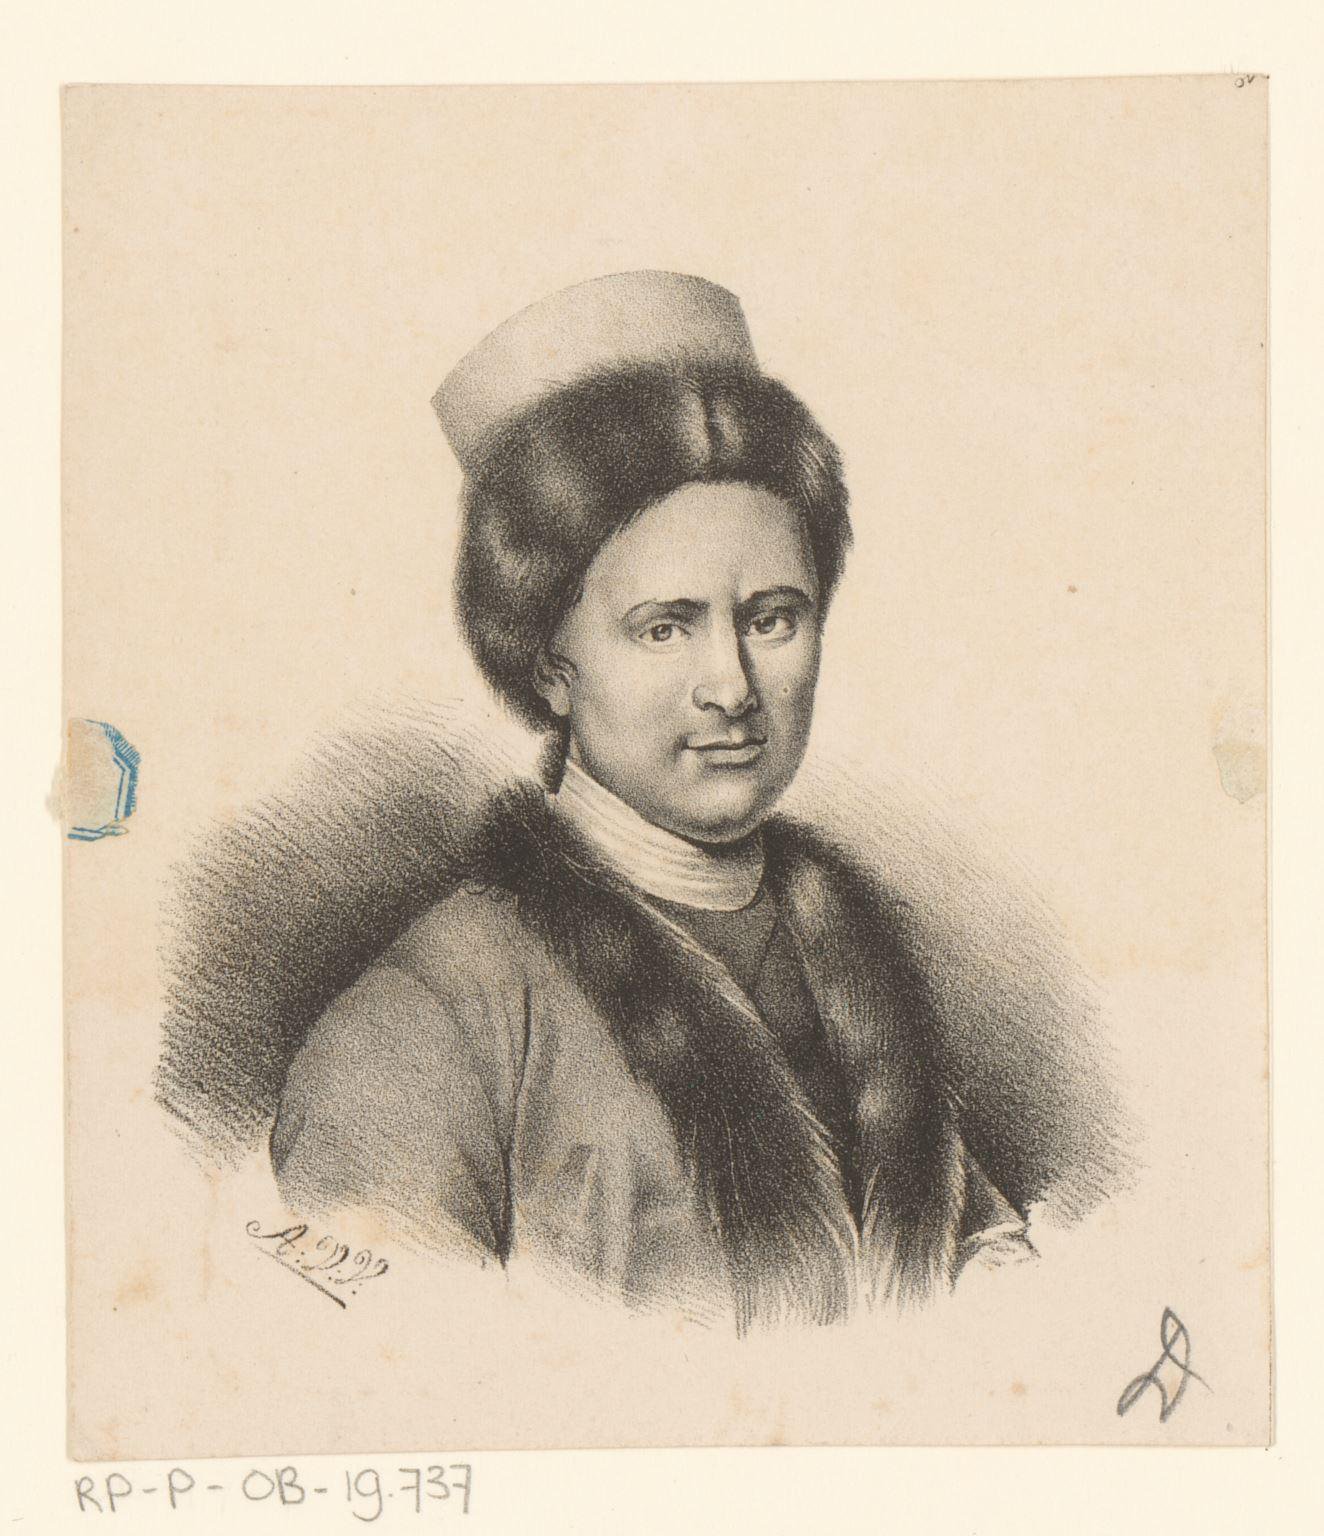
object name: print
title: Portret van Jean-Jacques Rousseau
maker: anthonie van volkom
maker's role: print maker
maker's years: 1821-1860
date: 1837-1840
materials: paper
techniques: lithograph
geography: paris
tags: anonymous historical person portrayed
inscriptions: collector's mark: Lugt 2228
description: Rousseau met bontmuts en jas met bontkraag. De vermelding van naam onder het portret is afgesneden.